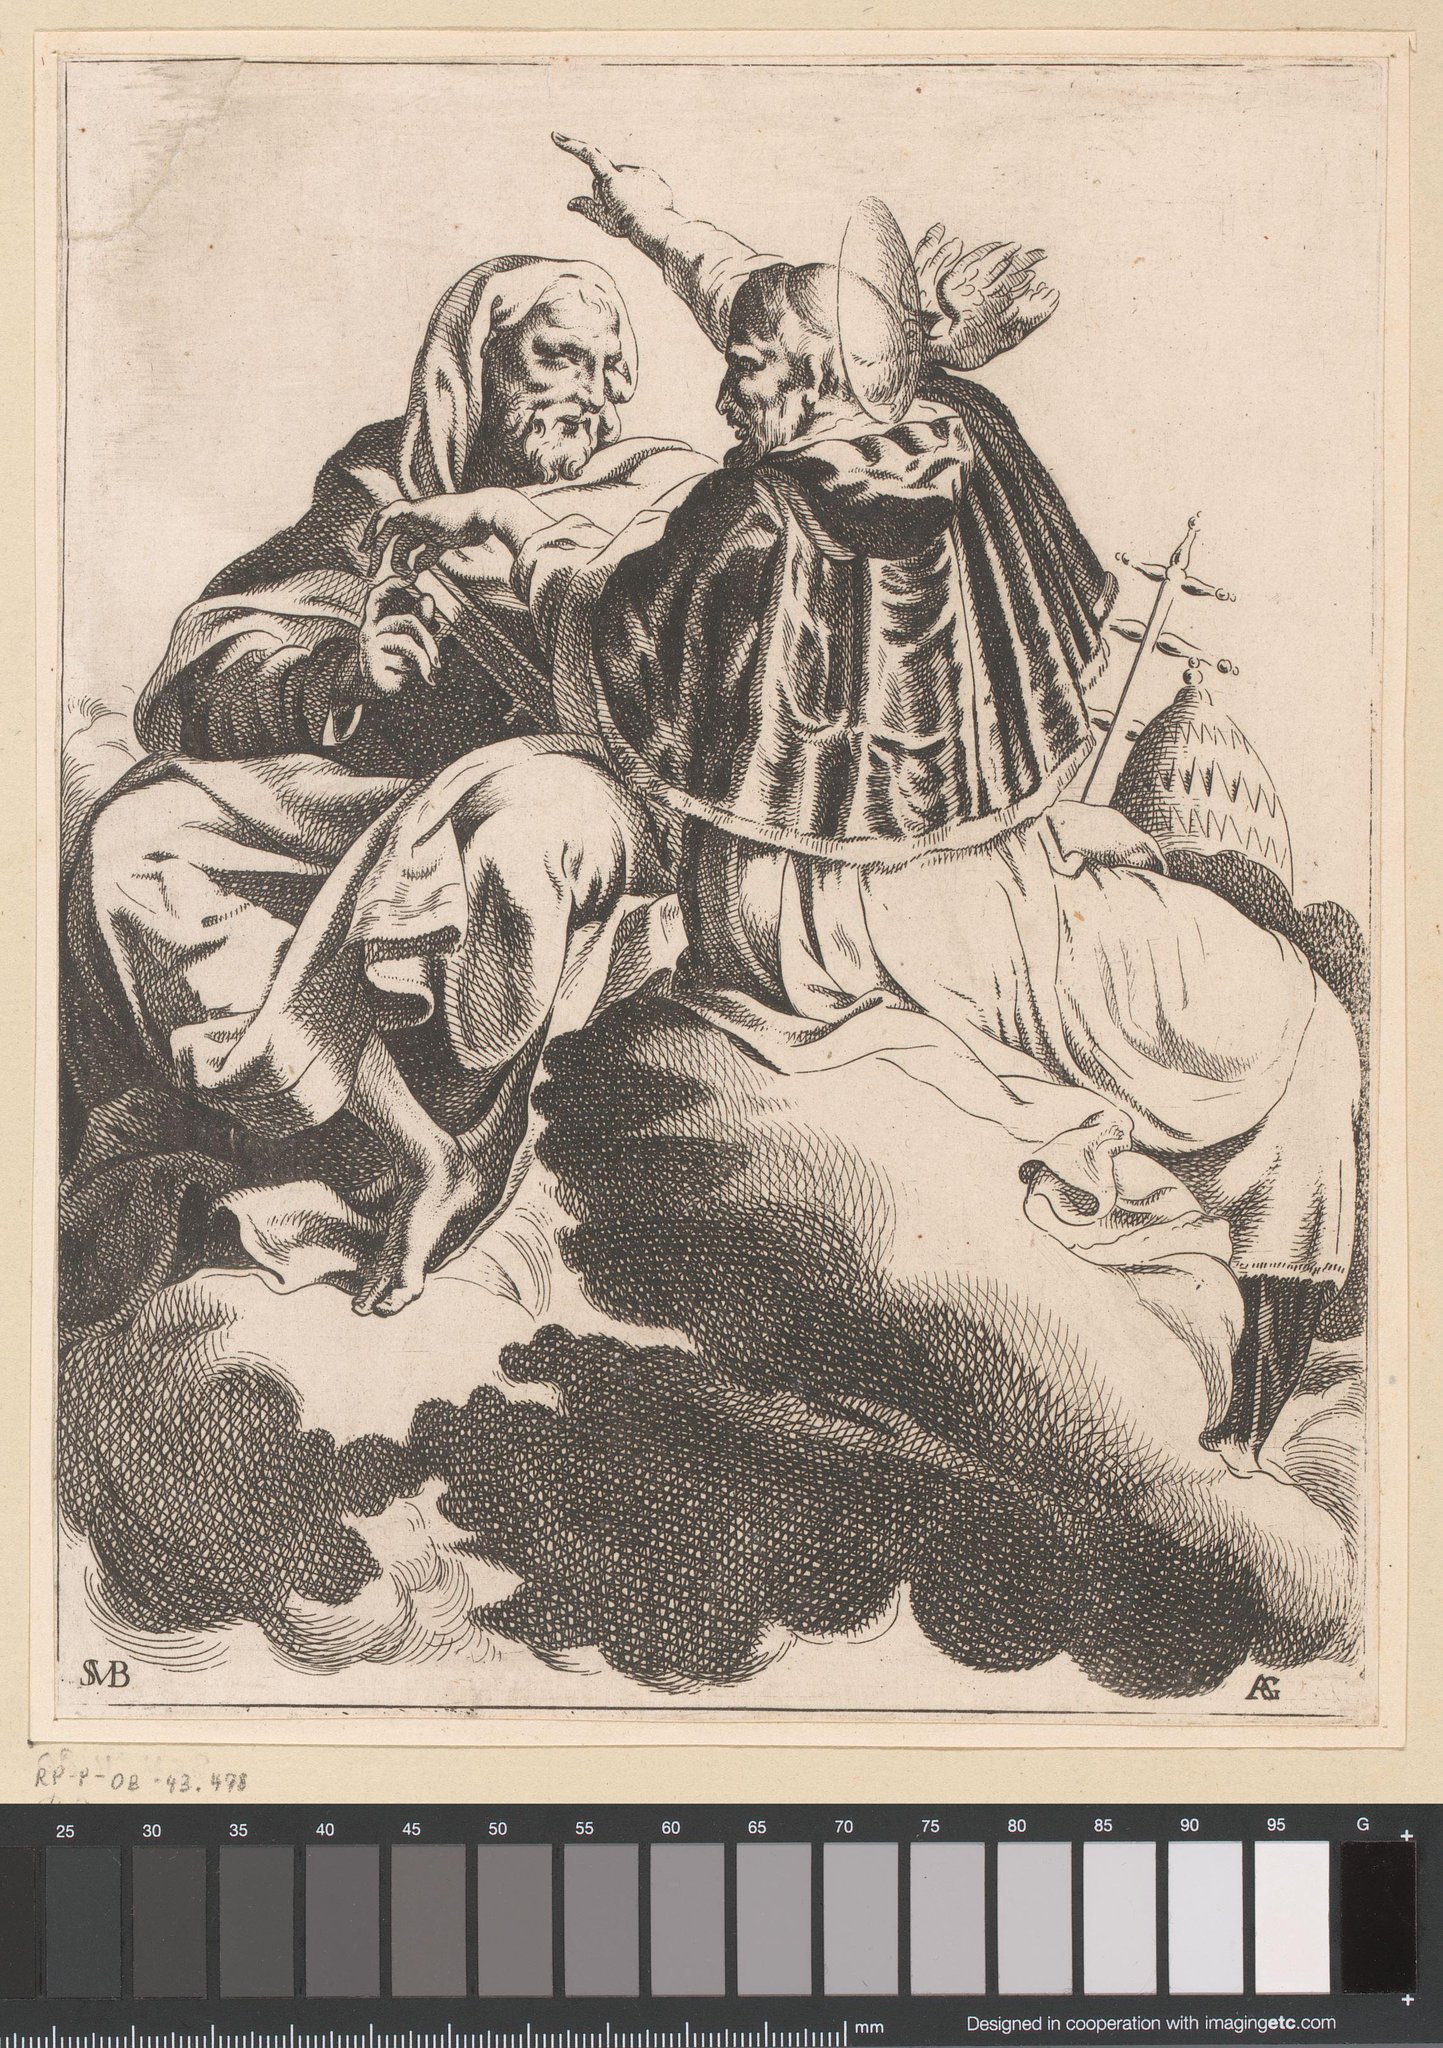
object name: print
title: Heiligen gezeten op wolken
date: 1621-1694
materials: paper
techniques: engraving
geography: france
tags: mark (marcus) the evangelist, and bishop of alexandria; possible attributes: book, (winged) lion, pen and inkhorn, scroll, sitting or standing on clouds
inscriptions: collector's mark: Lugt 240